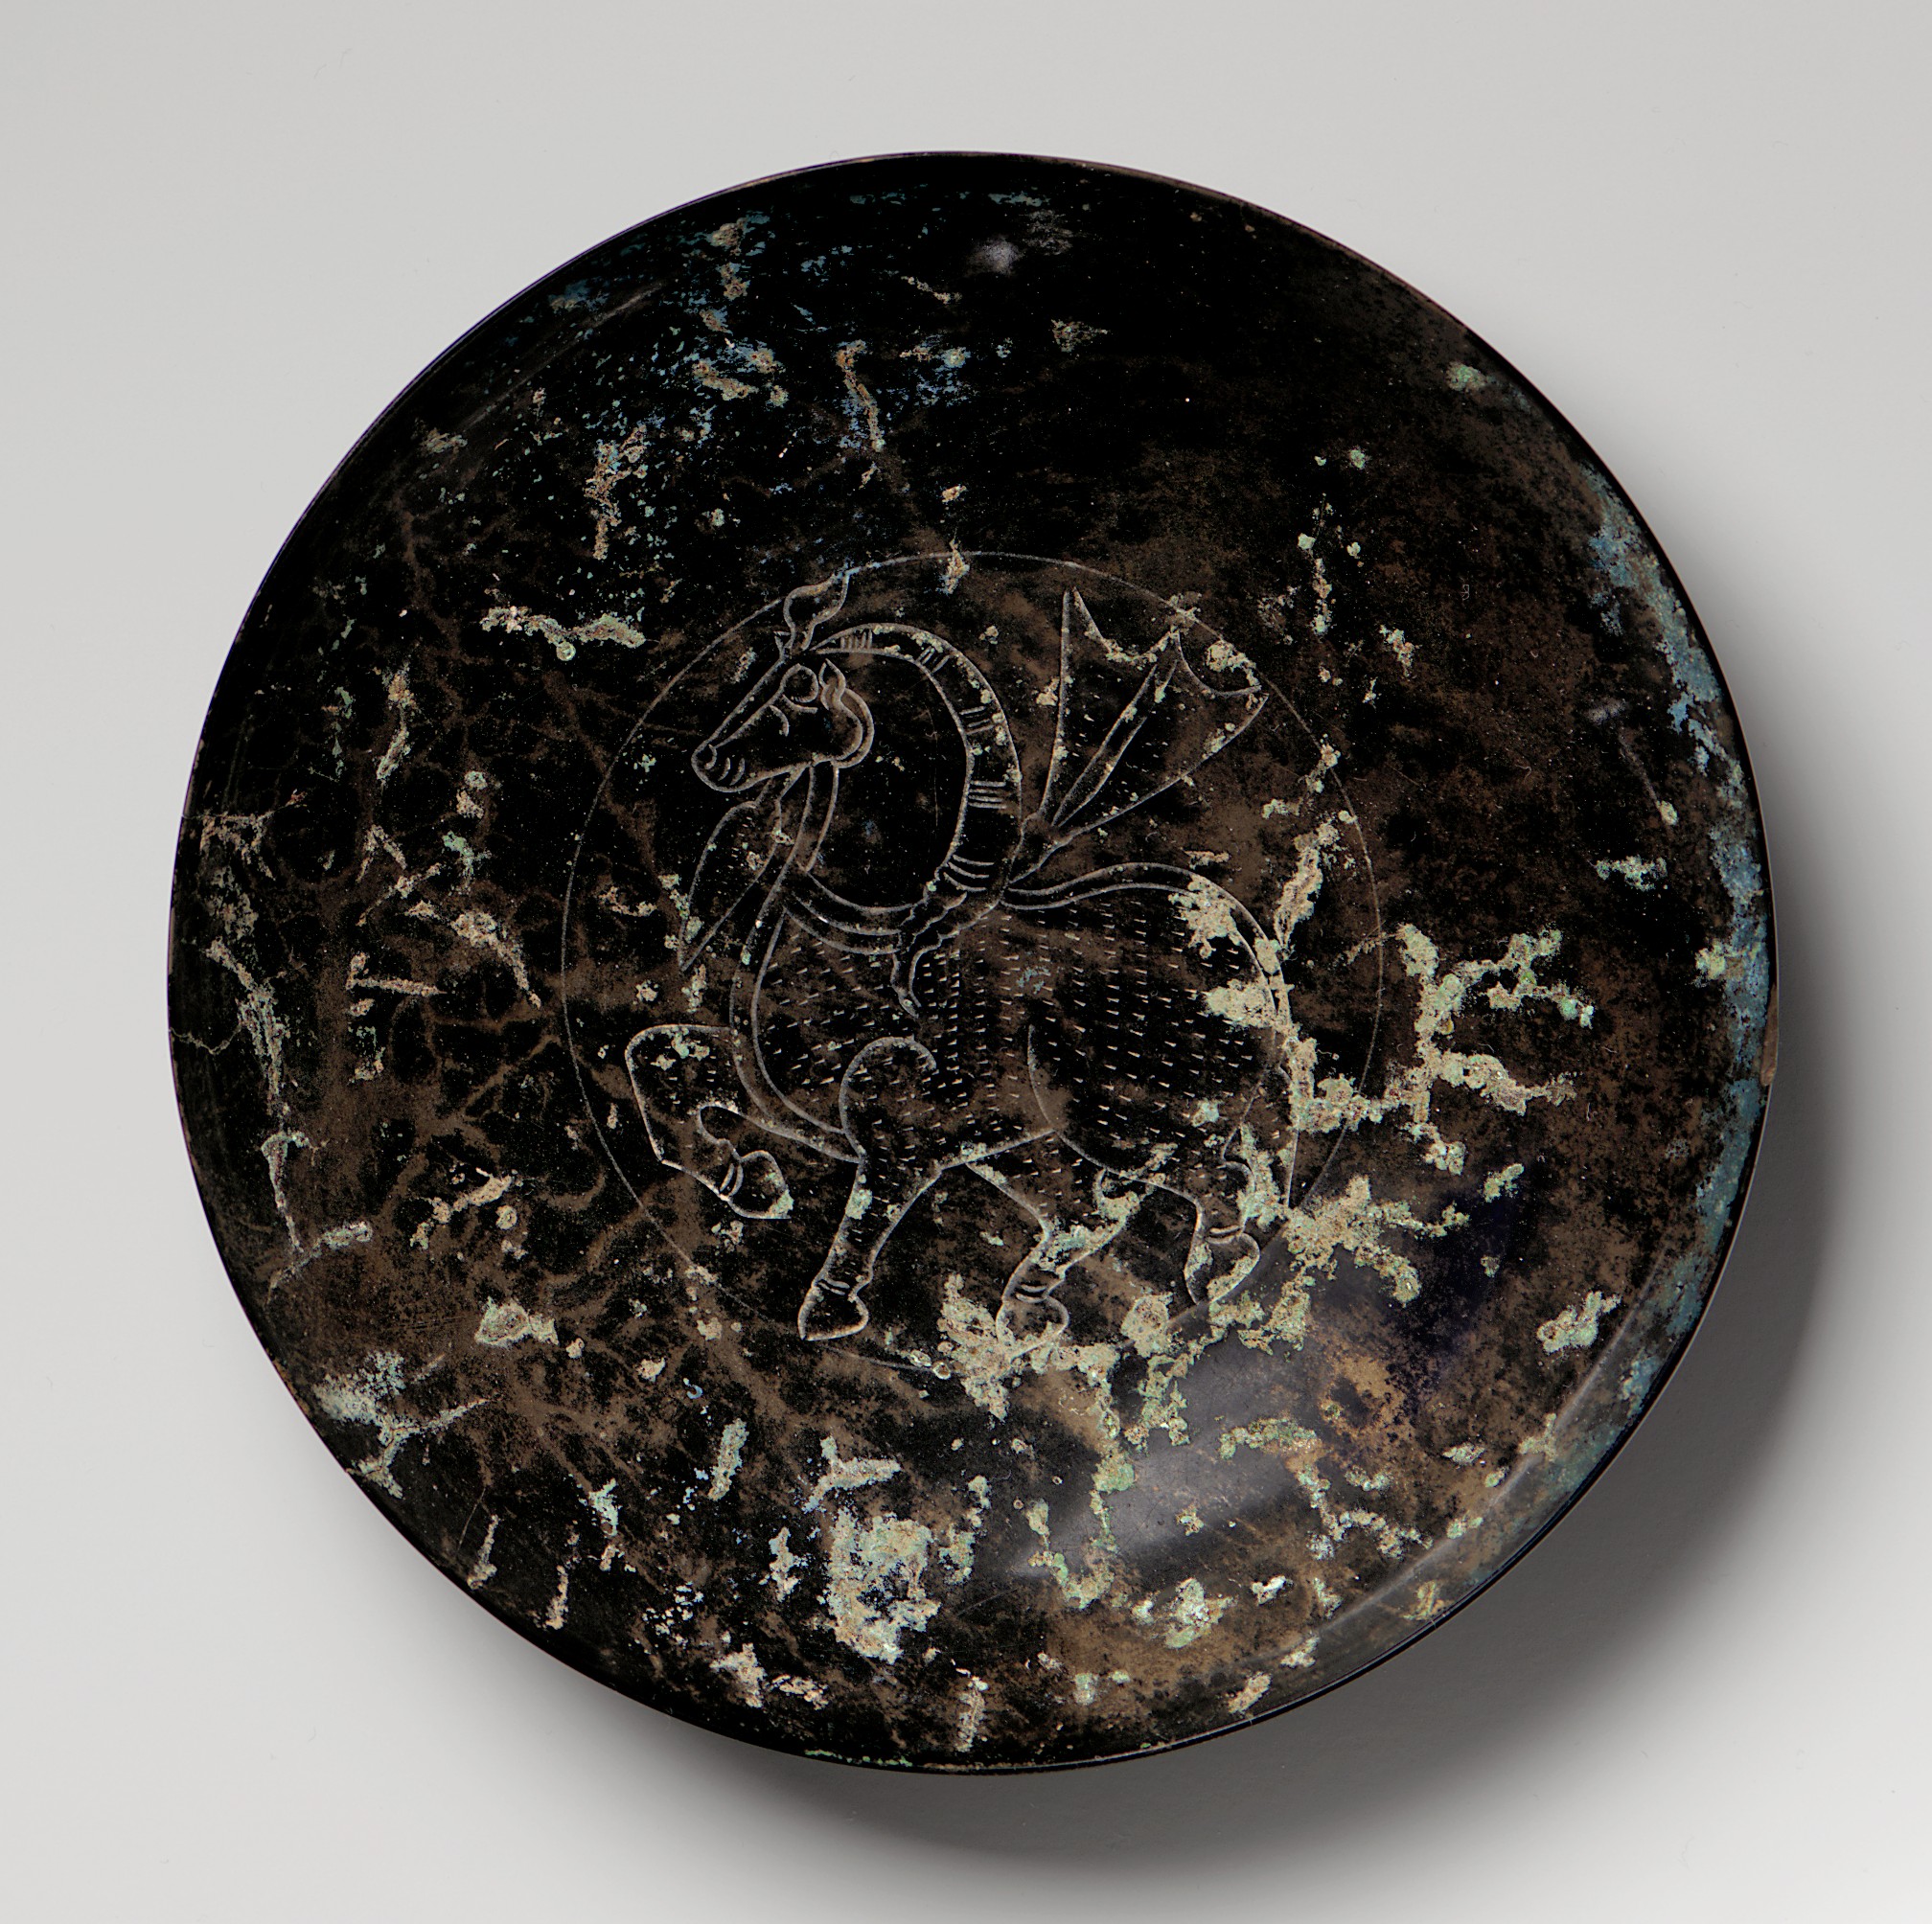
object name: plate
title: Plate with Horse Decoration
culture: central asia or iran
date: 601-900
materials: bronze, tin